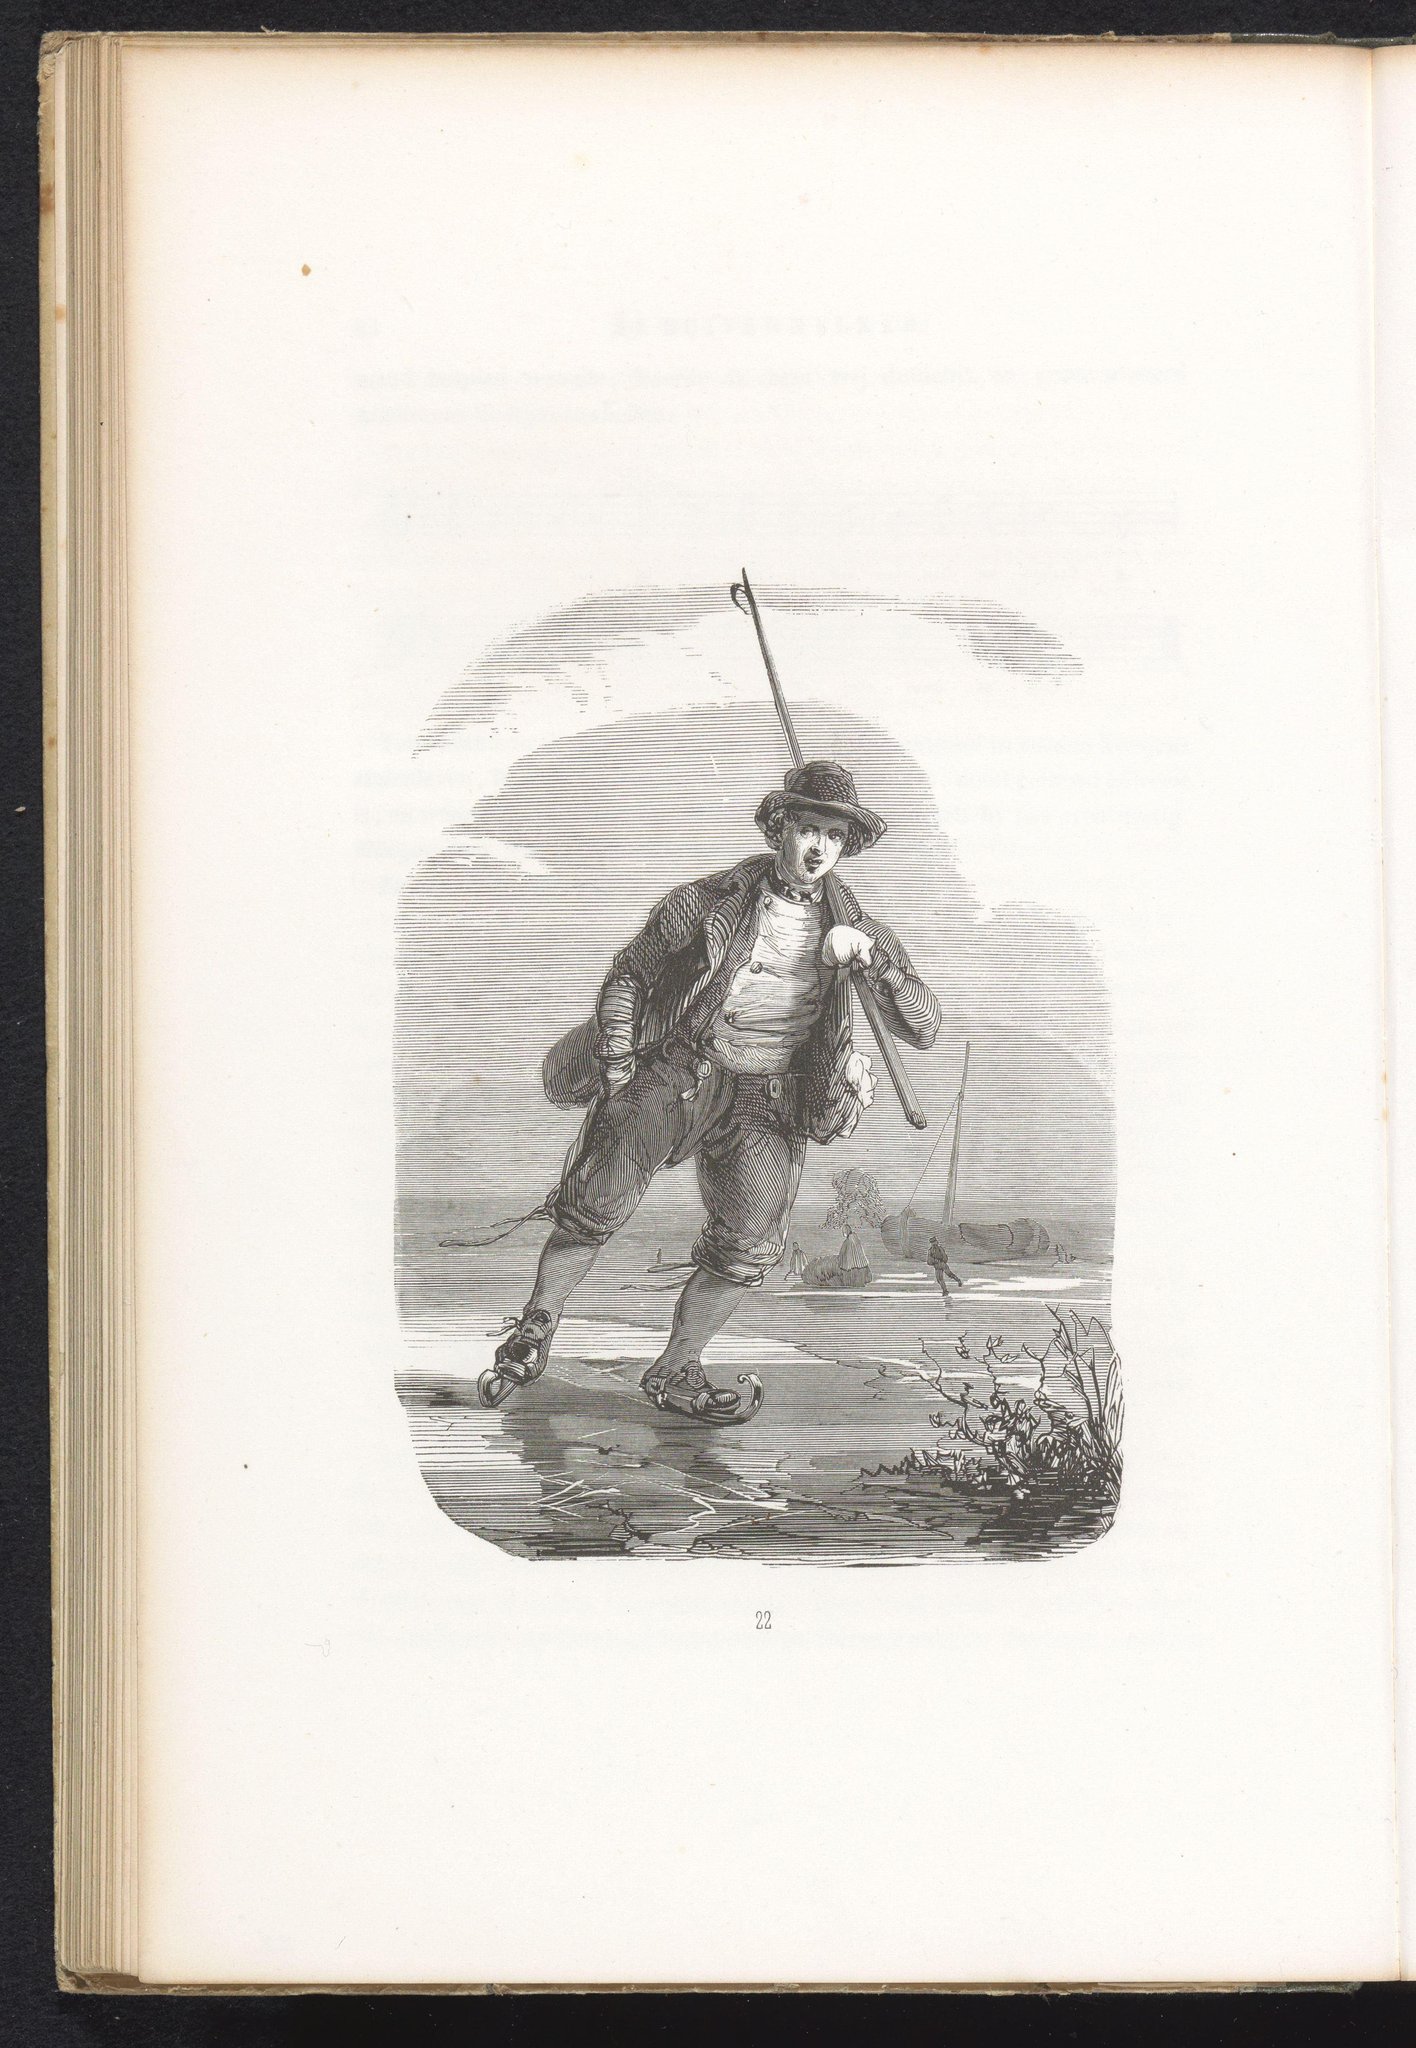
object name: book illustration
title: De schaatsenrijder, 1840-1841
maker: henry brown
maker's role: print maker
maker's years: 1816-1870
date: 1841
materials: paper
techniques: letterpress printing, engraving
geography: netherlands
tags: professional clothes, skates (winter sports), netherlands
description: De schaatsenrijder. Jonge man schaatsend op het ijs. Genummerd: 22. Illustratie in het boek 'De Nederlanden: karakterschetsen, kleederdrachten, houding en voorkomen van verschillende standen', een boek met karakterschetsen, beroepen en klederdrachten van Nederlandse volkstypen uit 1841.